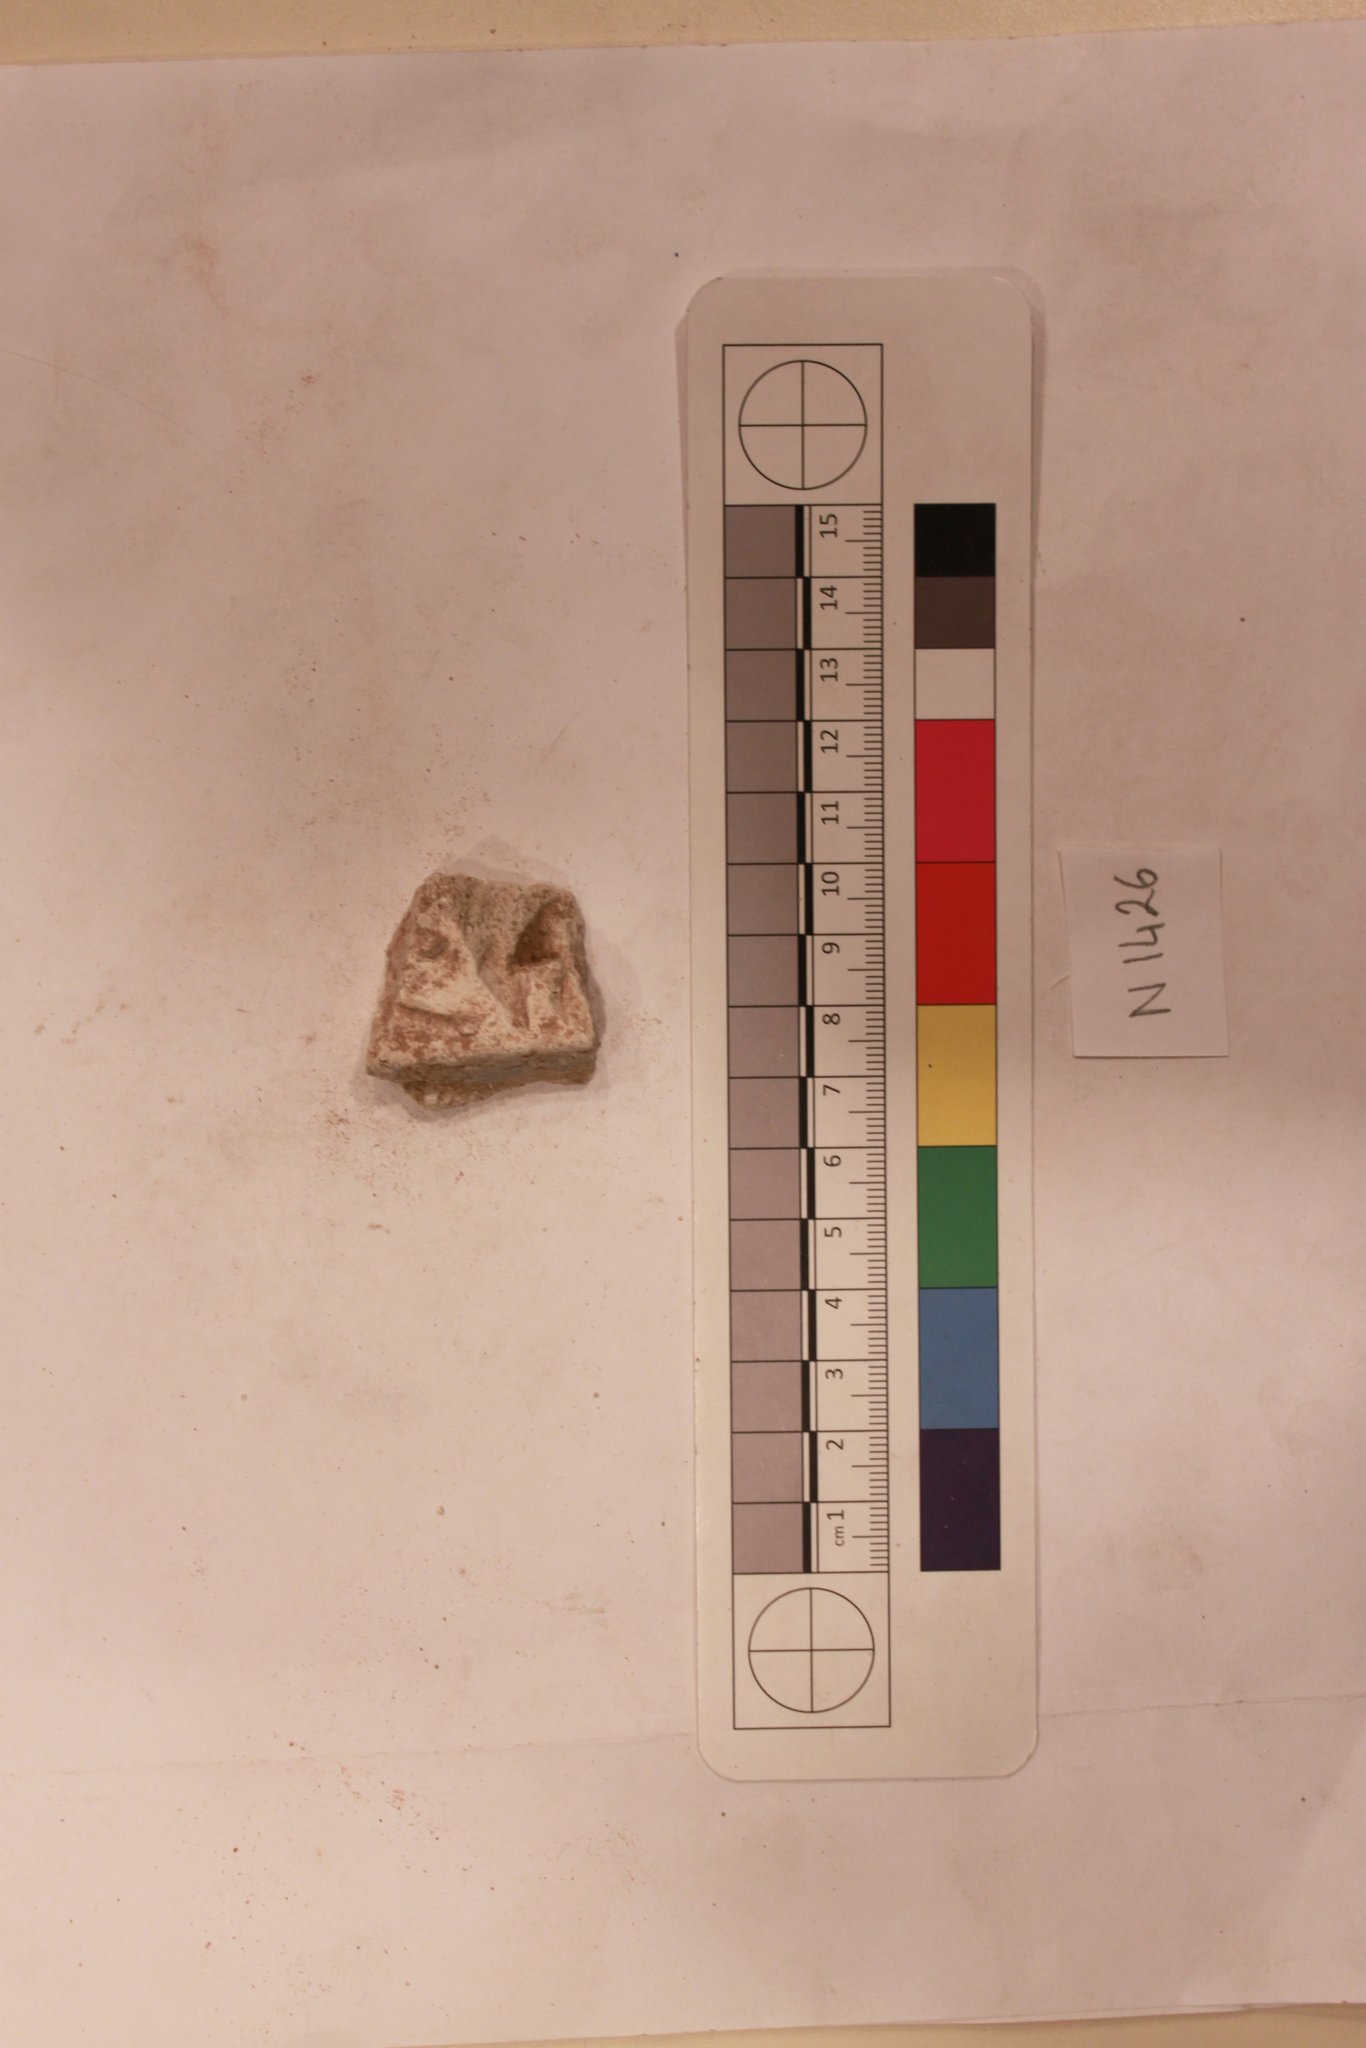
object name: fragment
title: Stucco Fragment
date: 701-1200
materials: plaster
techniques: carving, painting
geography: iran